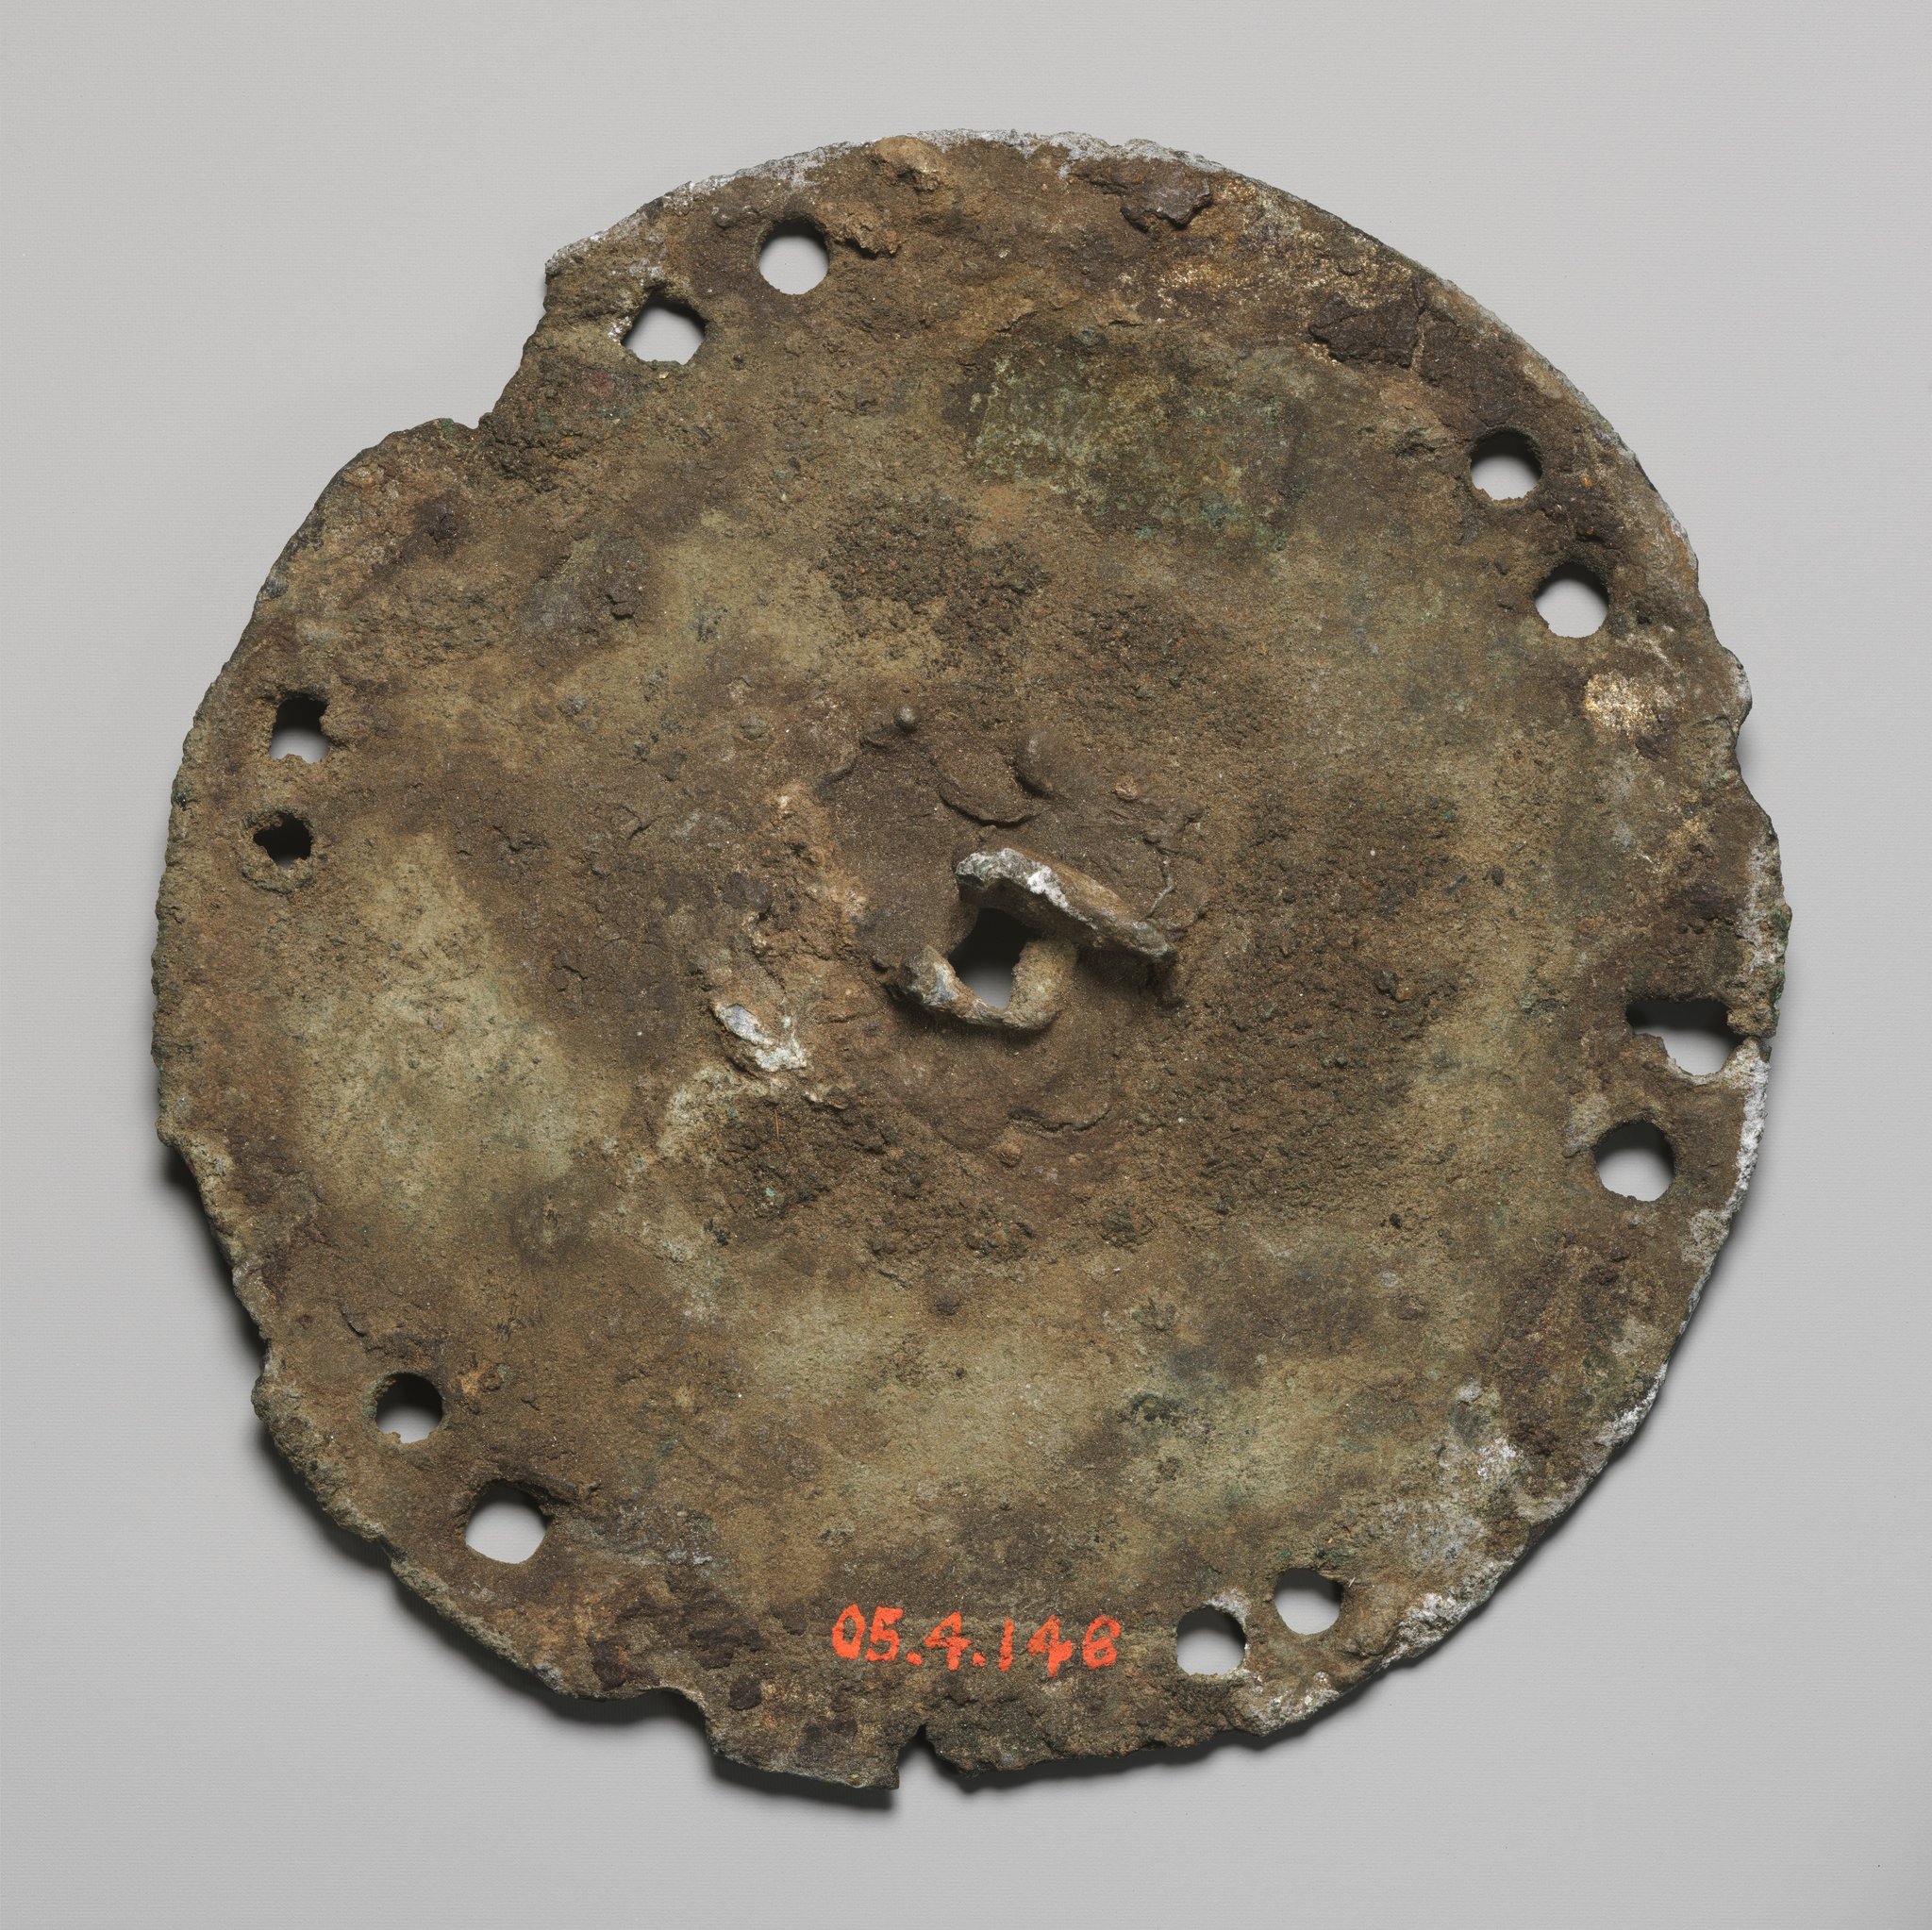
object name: disk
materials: copper alloy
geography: egypt